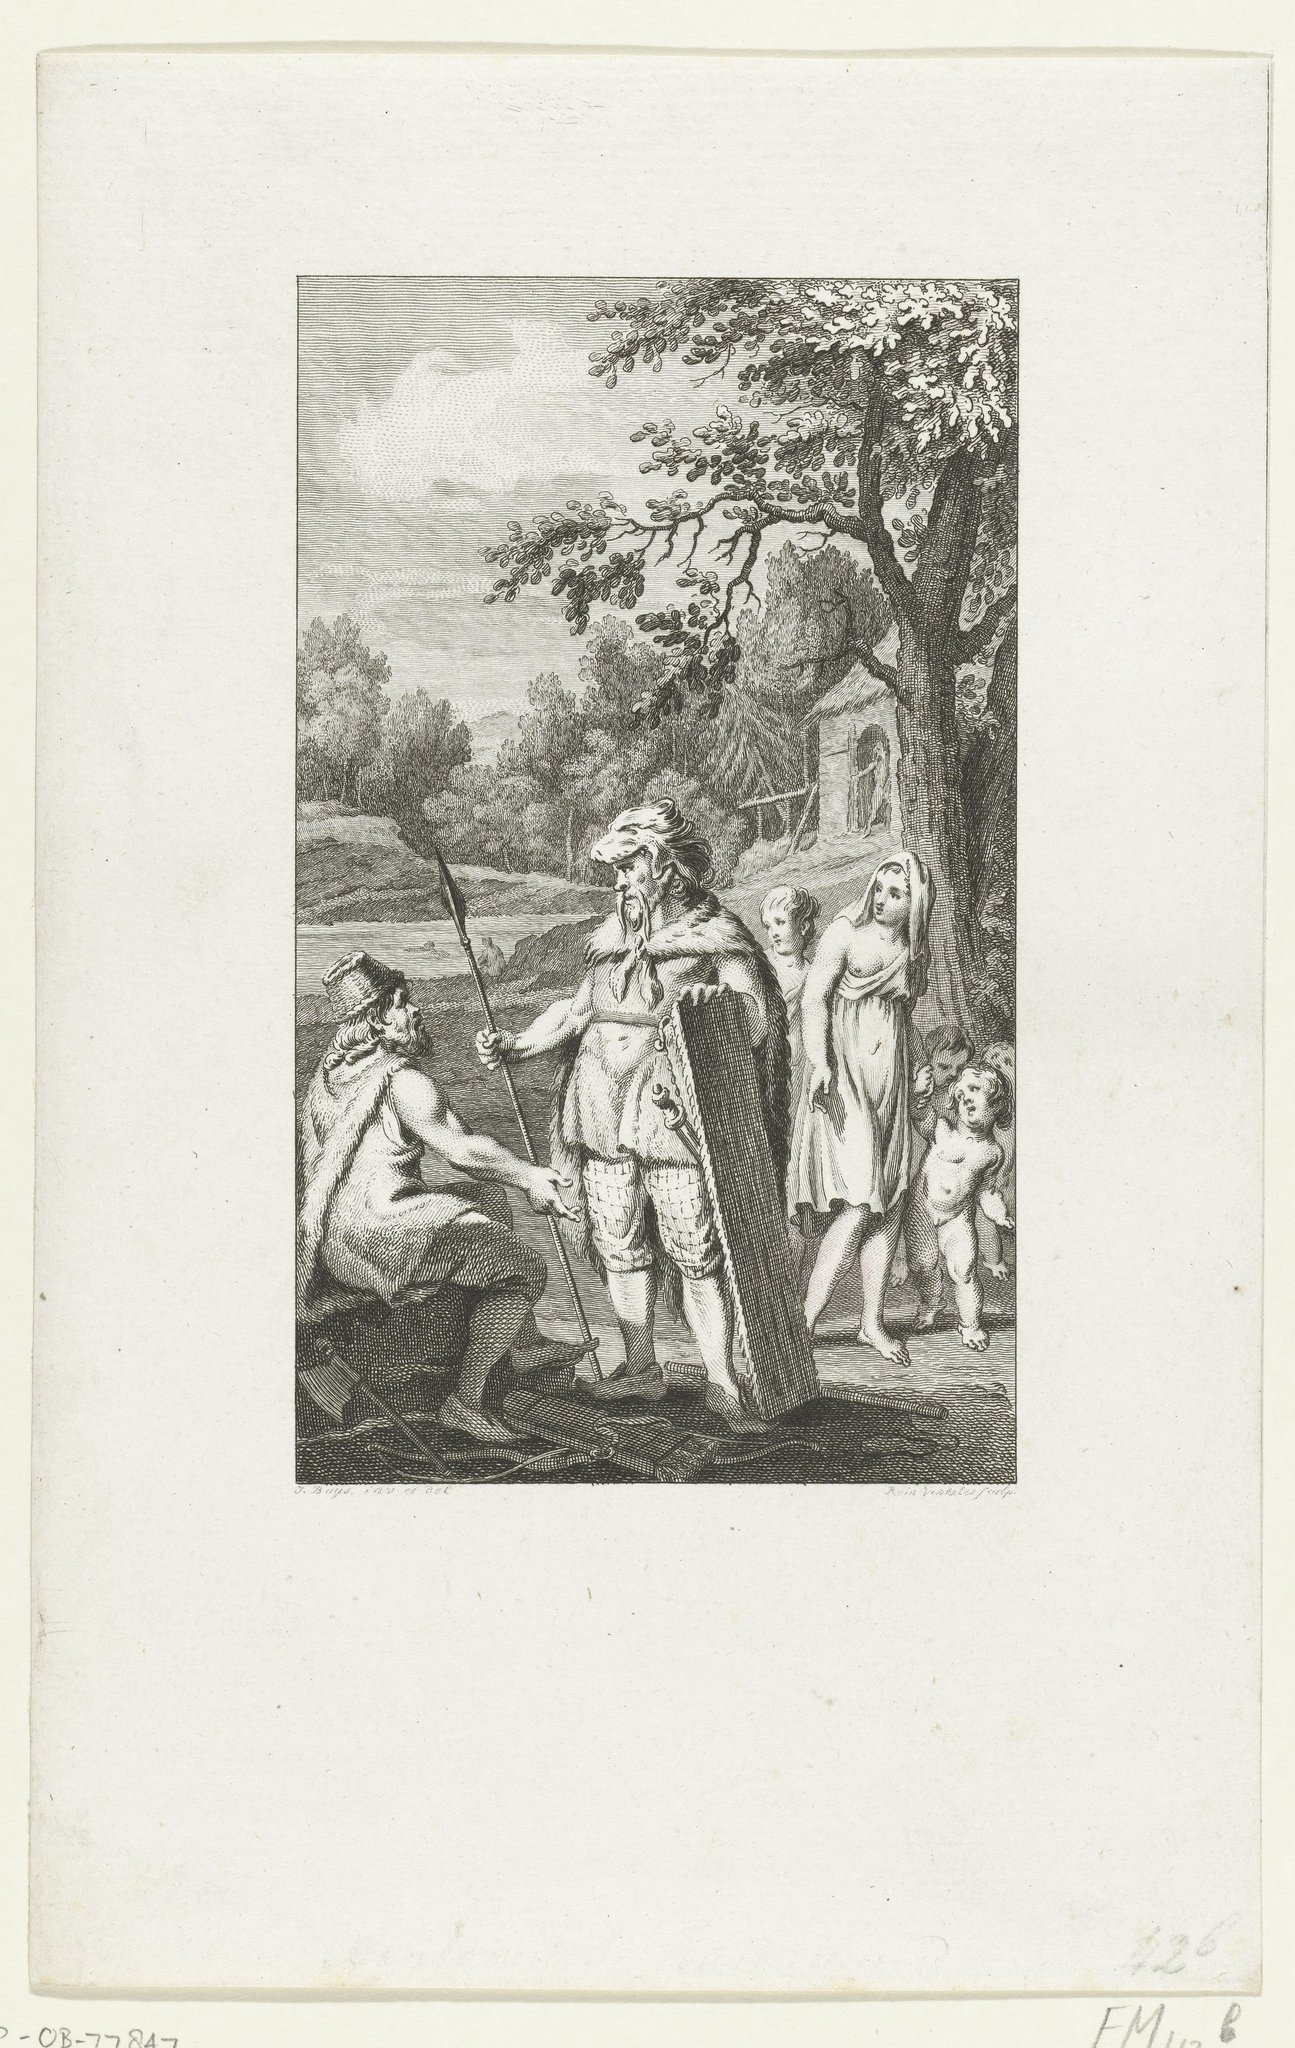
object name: print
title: Kleding en wapenrusting van de Bataven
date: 1784-1786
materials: paper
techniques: etching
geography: netherlands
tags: extinct, 'historical' peoples (with name), netherlands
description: Illustratie voor: Jacobus Kok, Vaderlandsch Woordenboek, Johannes Allart, Amsterdam 1785-1799, 35 delen, dl. V, pl. III. Staat vóór de letter.